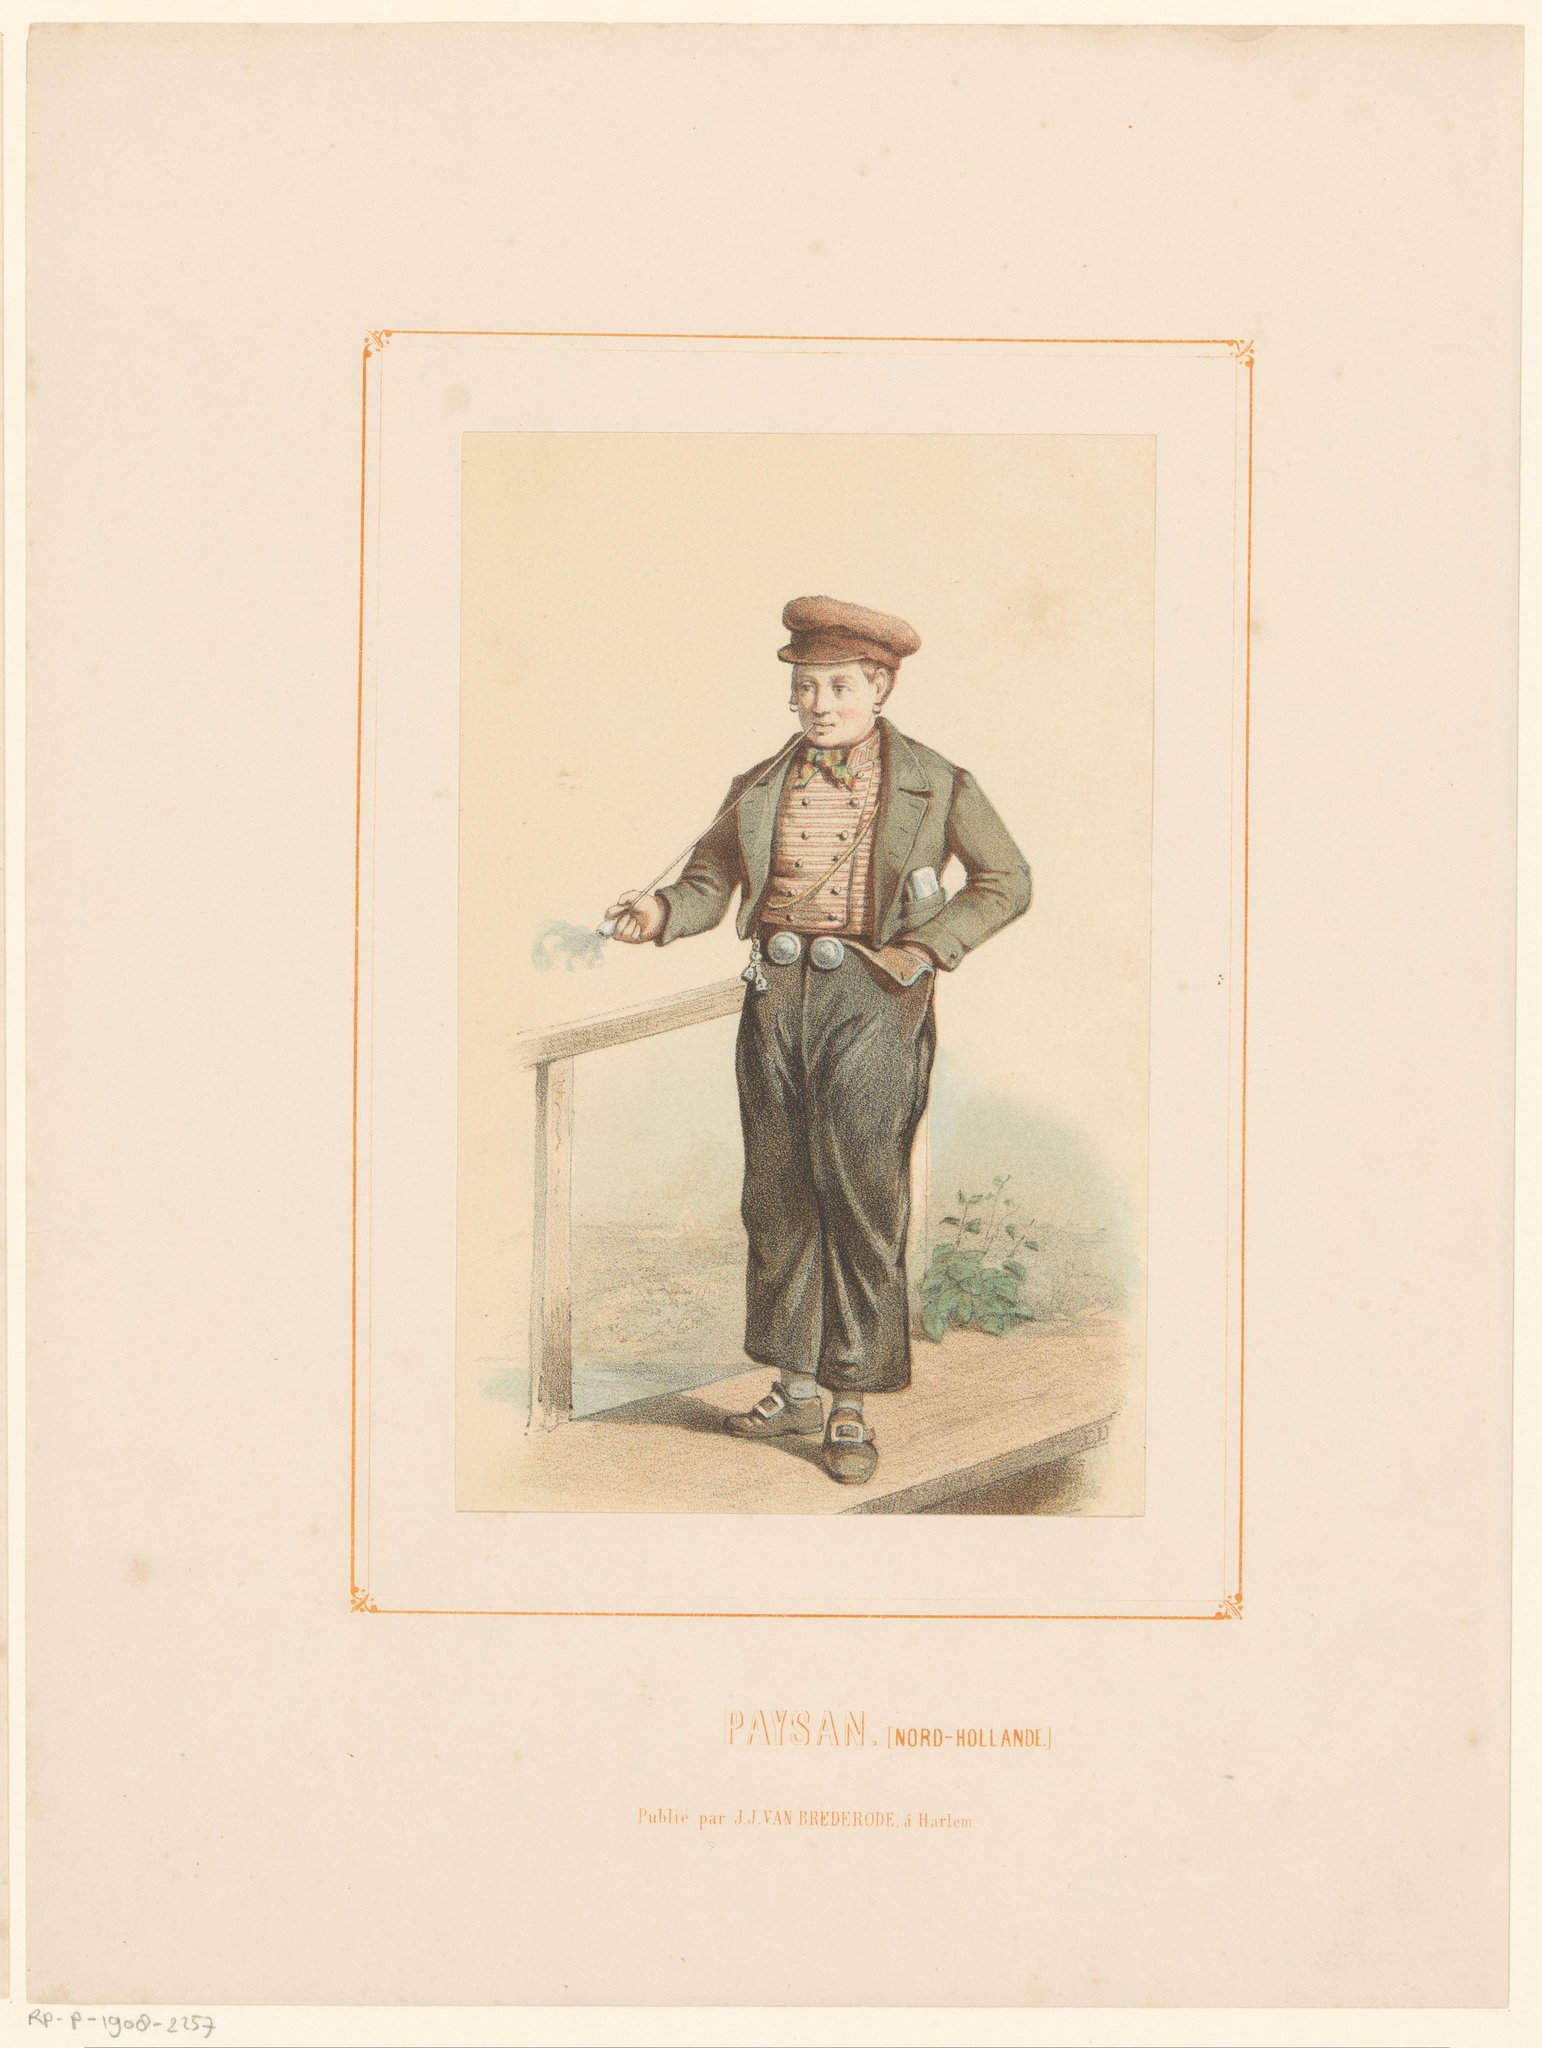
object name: print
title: Paysan. [Nord-Hollande.]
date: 1849-1873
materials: paper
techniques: lithograph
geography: haarlem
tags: pipe ~ tobacco, folk costume, regional costume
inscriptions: monogram: ‘E.D.’, collector's mark: Lugt 2228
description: De boer staat op een brug en rookt een pijp.